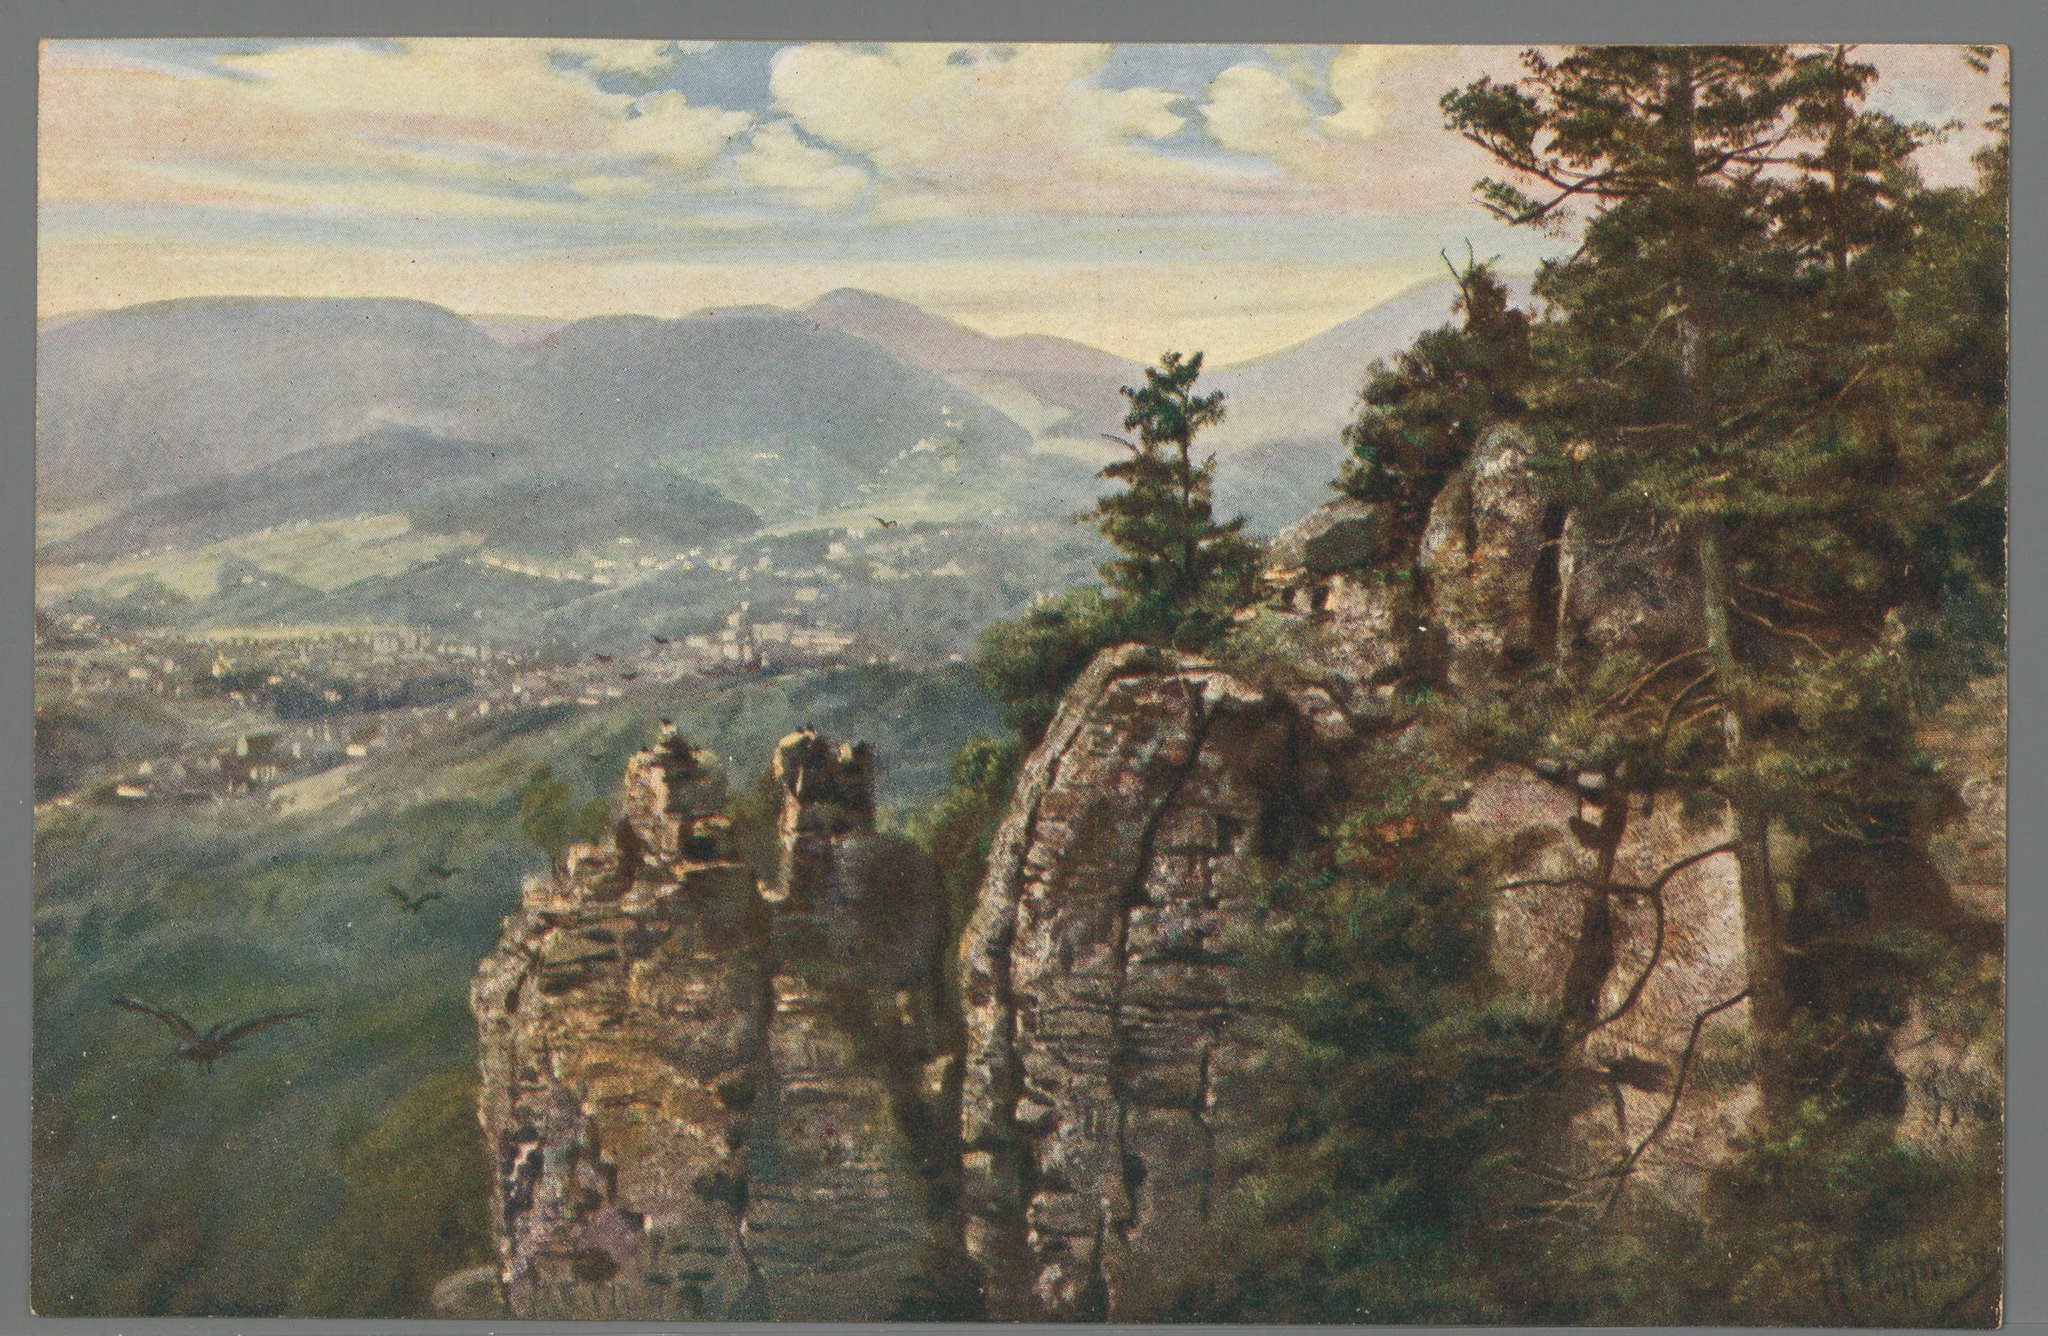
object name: reproduction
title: Baden-Baden - Partie mit den Felsen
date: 1905-1930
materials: cardboard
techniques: color autotype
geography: heidelberg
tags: mountains